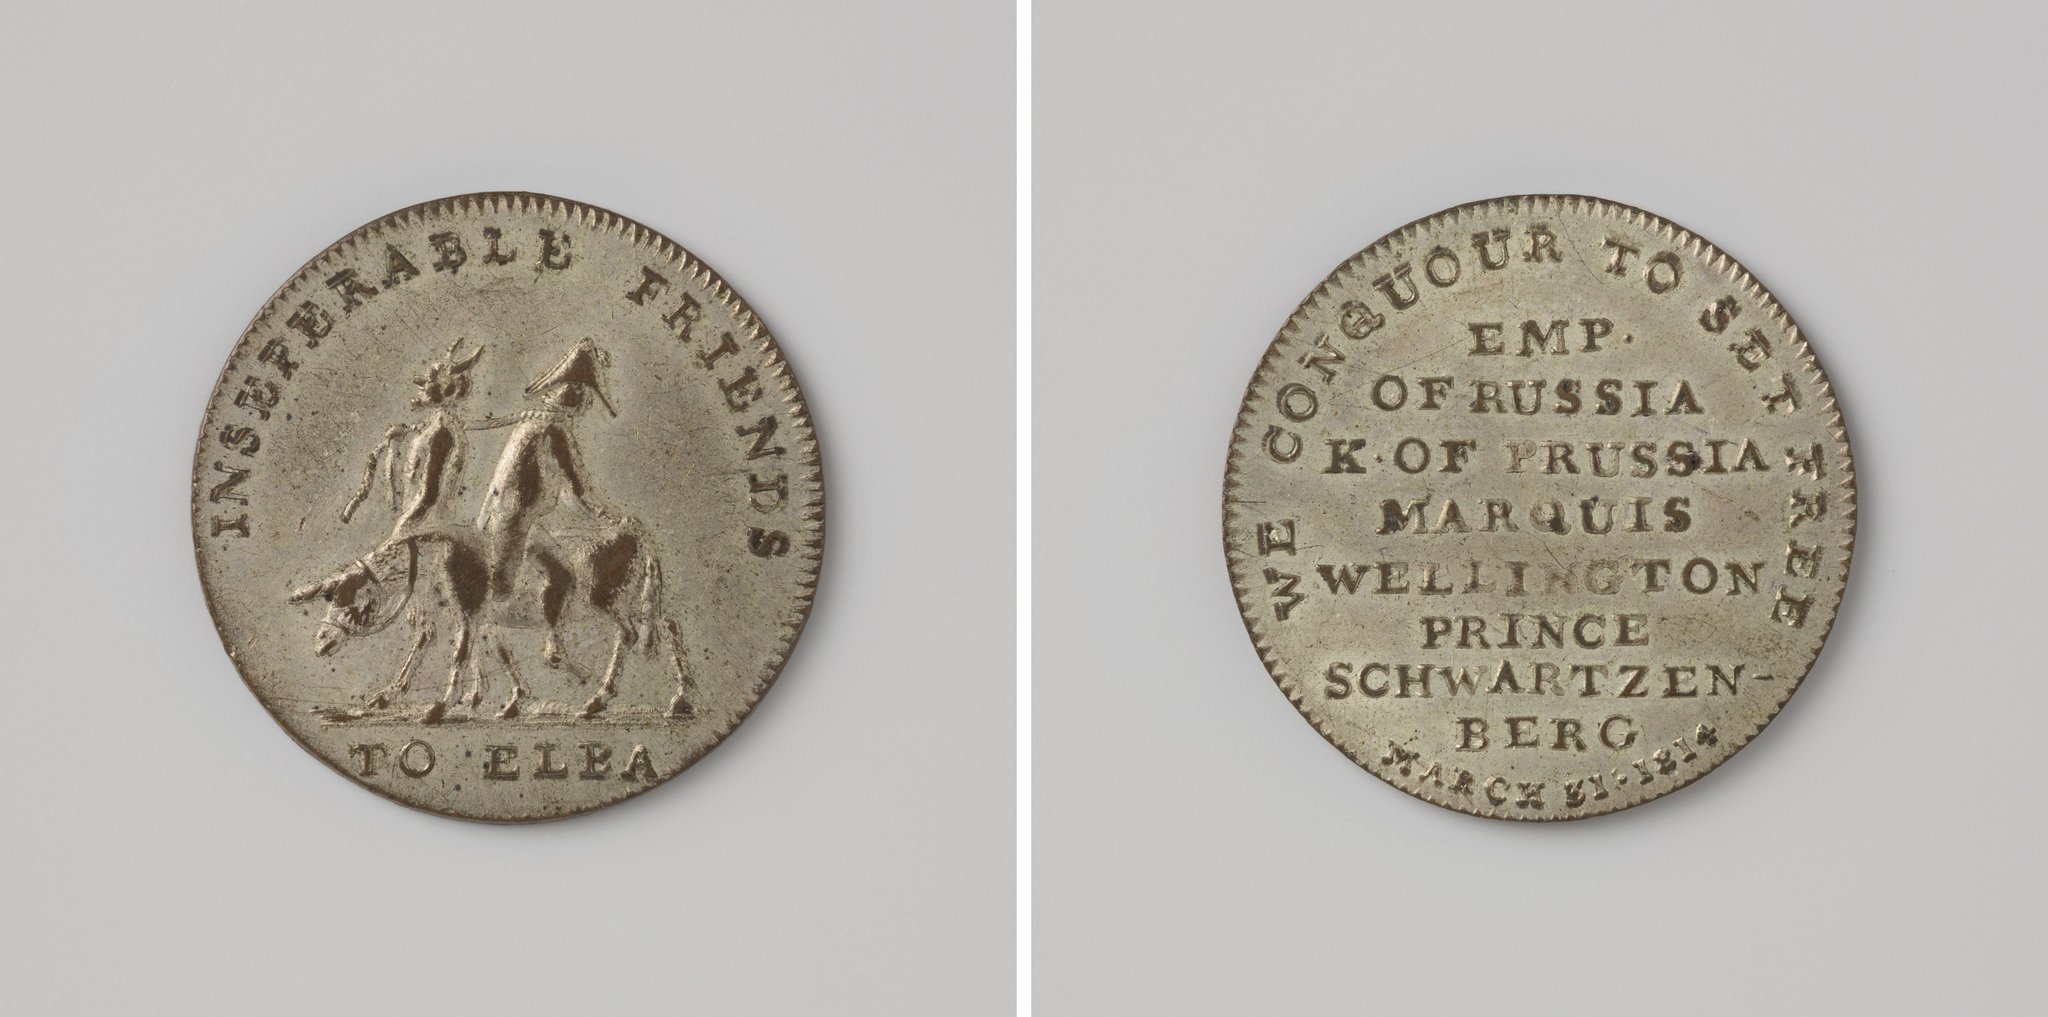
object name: jeton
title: Inname van Parijs door de geallieerden en verbanning van Napoleon I Bonaparte, keizer der Fransen naar Elba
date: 1815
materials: silver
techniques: striking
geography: birmingham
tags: walmer castle, arthur wellesley of wellington, napoleon i (emperor of the french), alexander i (tsaar van rusland), berlin, frederik willem iii koning van pruisen, paris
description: Zilveren penning. Voorzijde: Napoleon met touw om zijn nek, dat door duivel wordt vastgehouden, zit omgekeerd op ezel binnen omschrift; afsnede: opschrift. Keerzijde: opschrift binnen omschrift